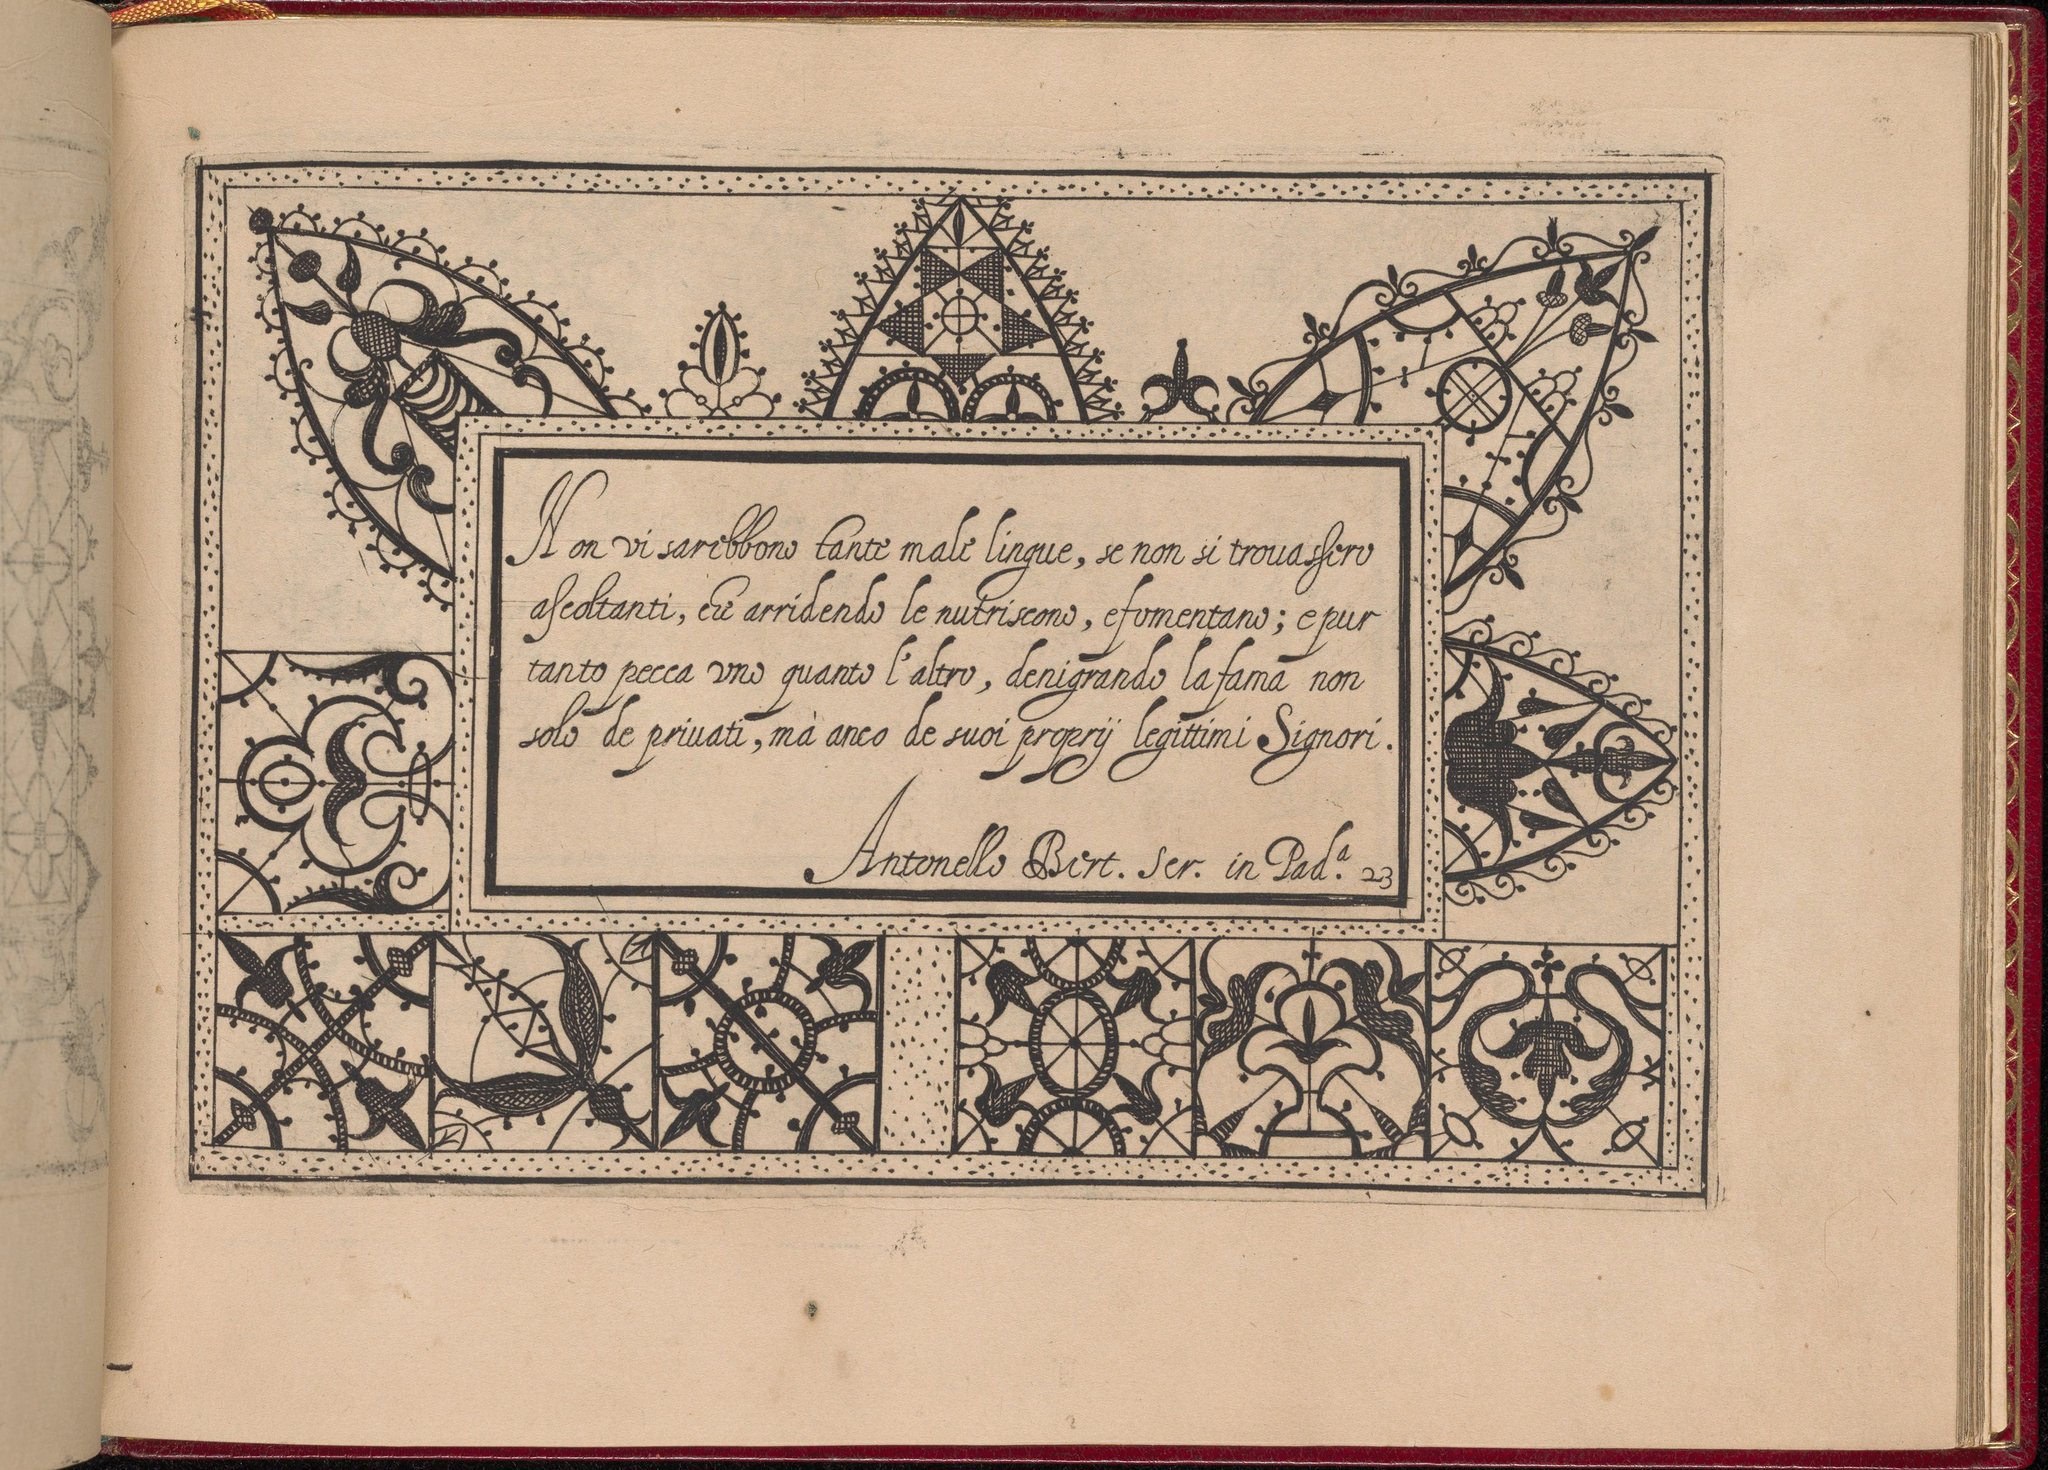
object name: book print ornament architecture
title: Ghirlanda: Di sei vaghi fiori scielti da piu famosi Giardini d'Italia, page 31 (recto)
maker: pietro paulo tozzi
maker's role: designer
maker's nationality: italian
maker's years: 1593-1628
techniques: drawing, etching